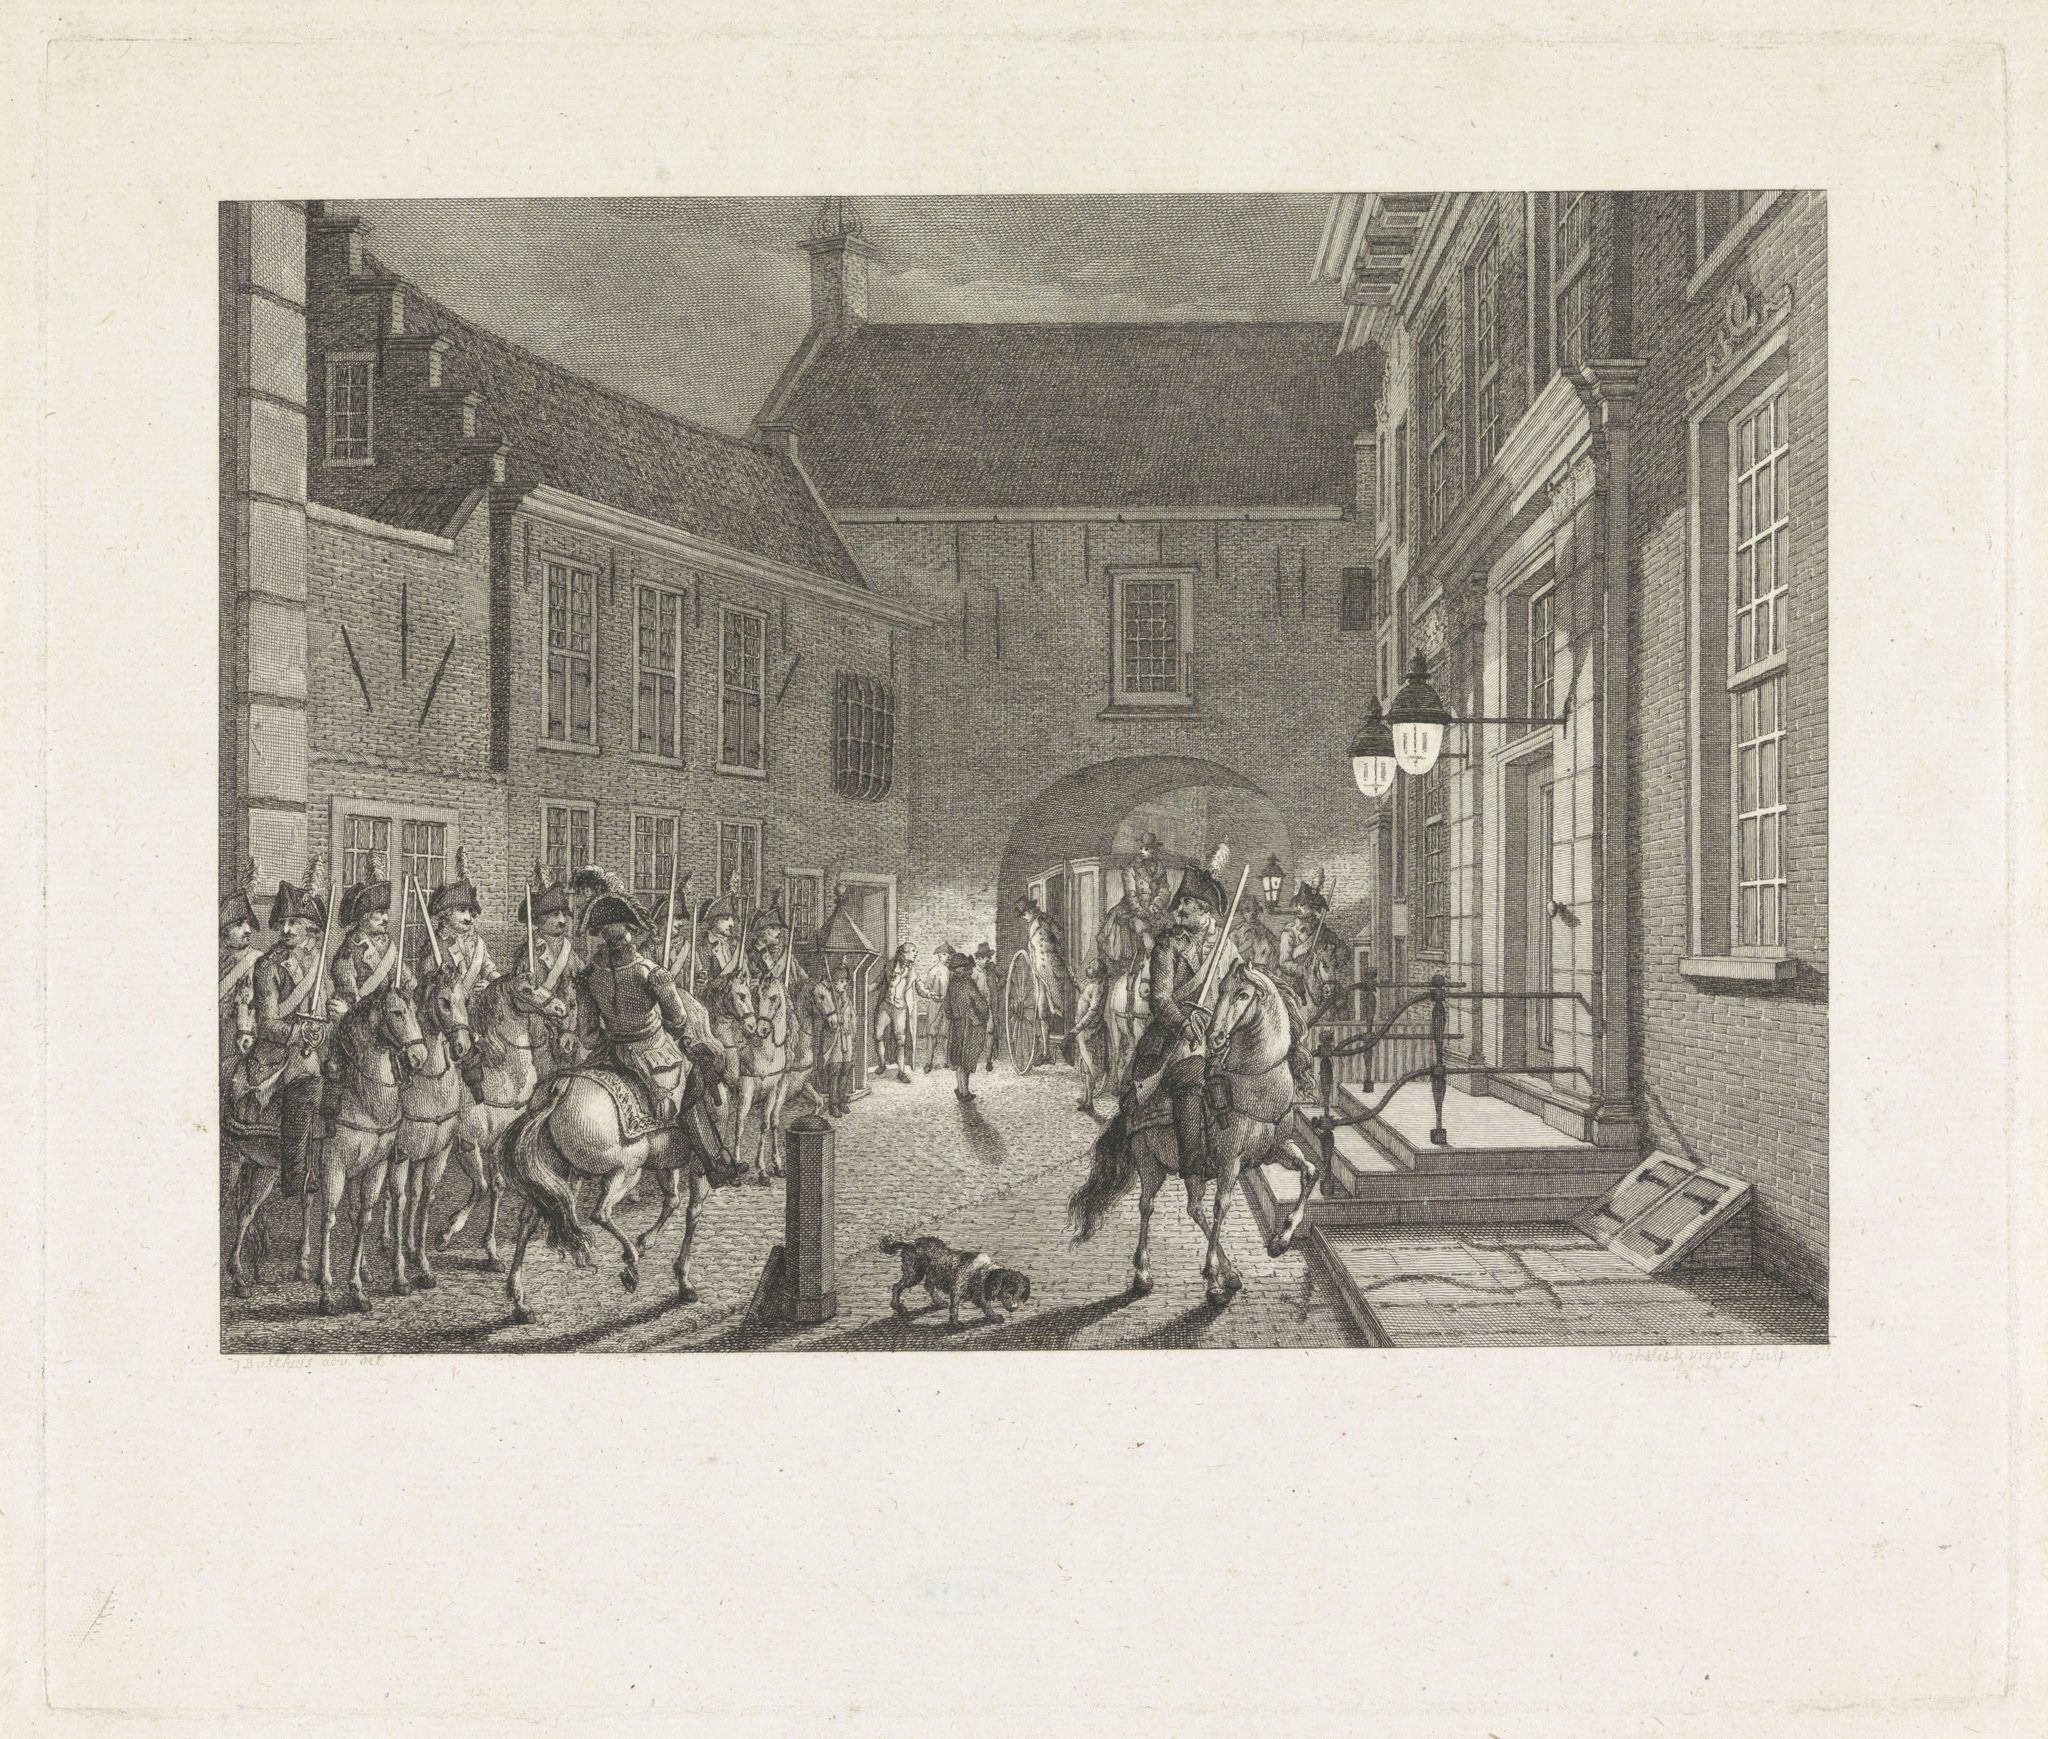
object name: print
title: L.P. van de Spiegel naar de Gevangenpoort gebracht, 1795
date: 1796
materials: paper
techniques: engraving, etching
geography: netherlands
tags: transport (of arrested person)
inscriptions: collector's mark: Lugt 2228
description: De voormalige raadspensionaris Laurens Pieter van de Spiegel wordt 's avonds naar de Gevangenpoort te Den Haag overgebracht, 14 oktober 1795. Spiegel stapt uit het rijtuig, op de voorgrond links een escorte soldaten te paard.